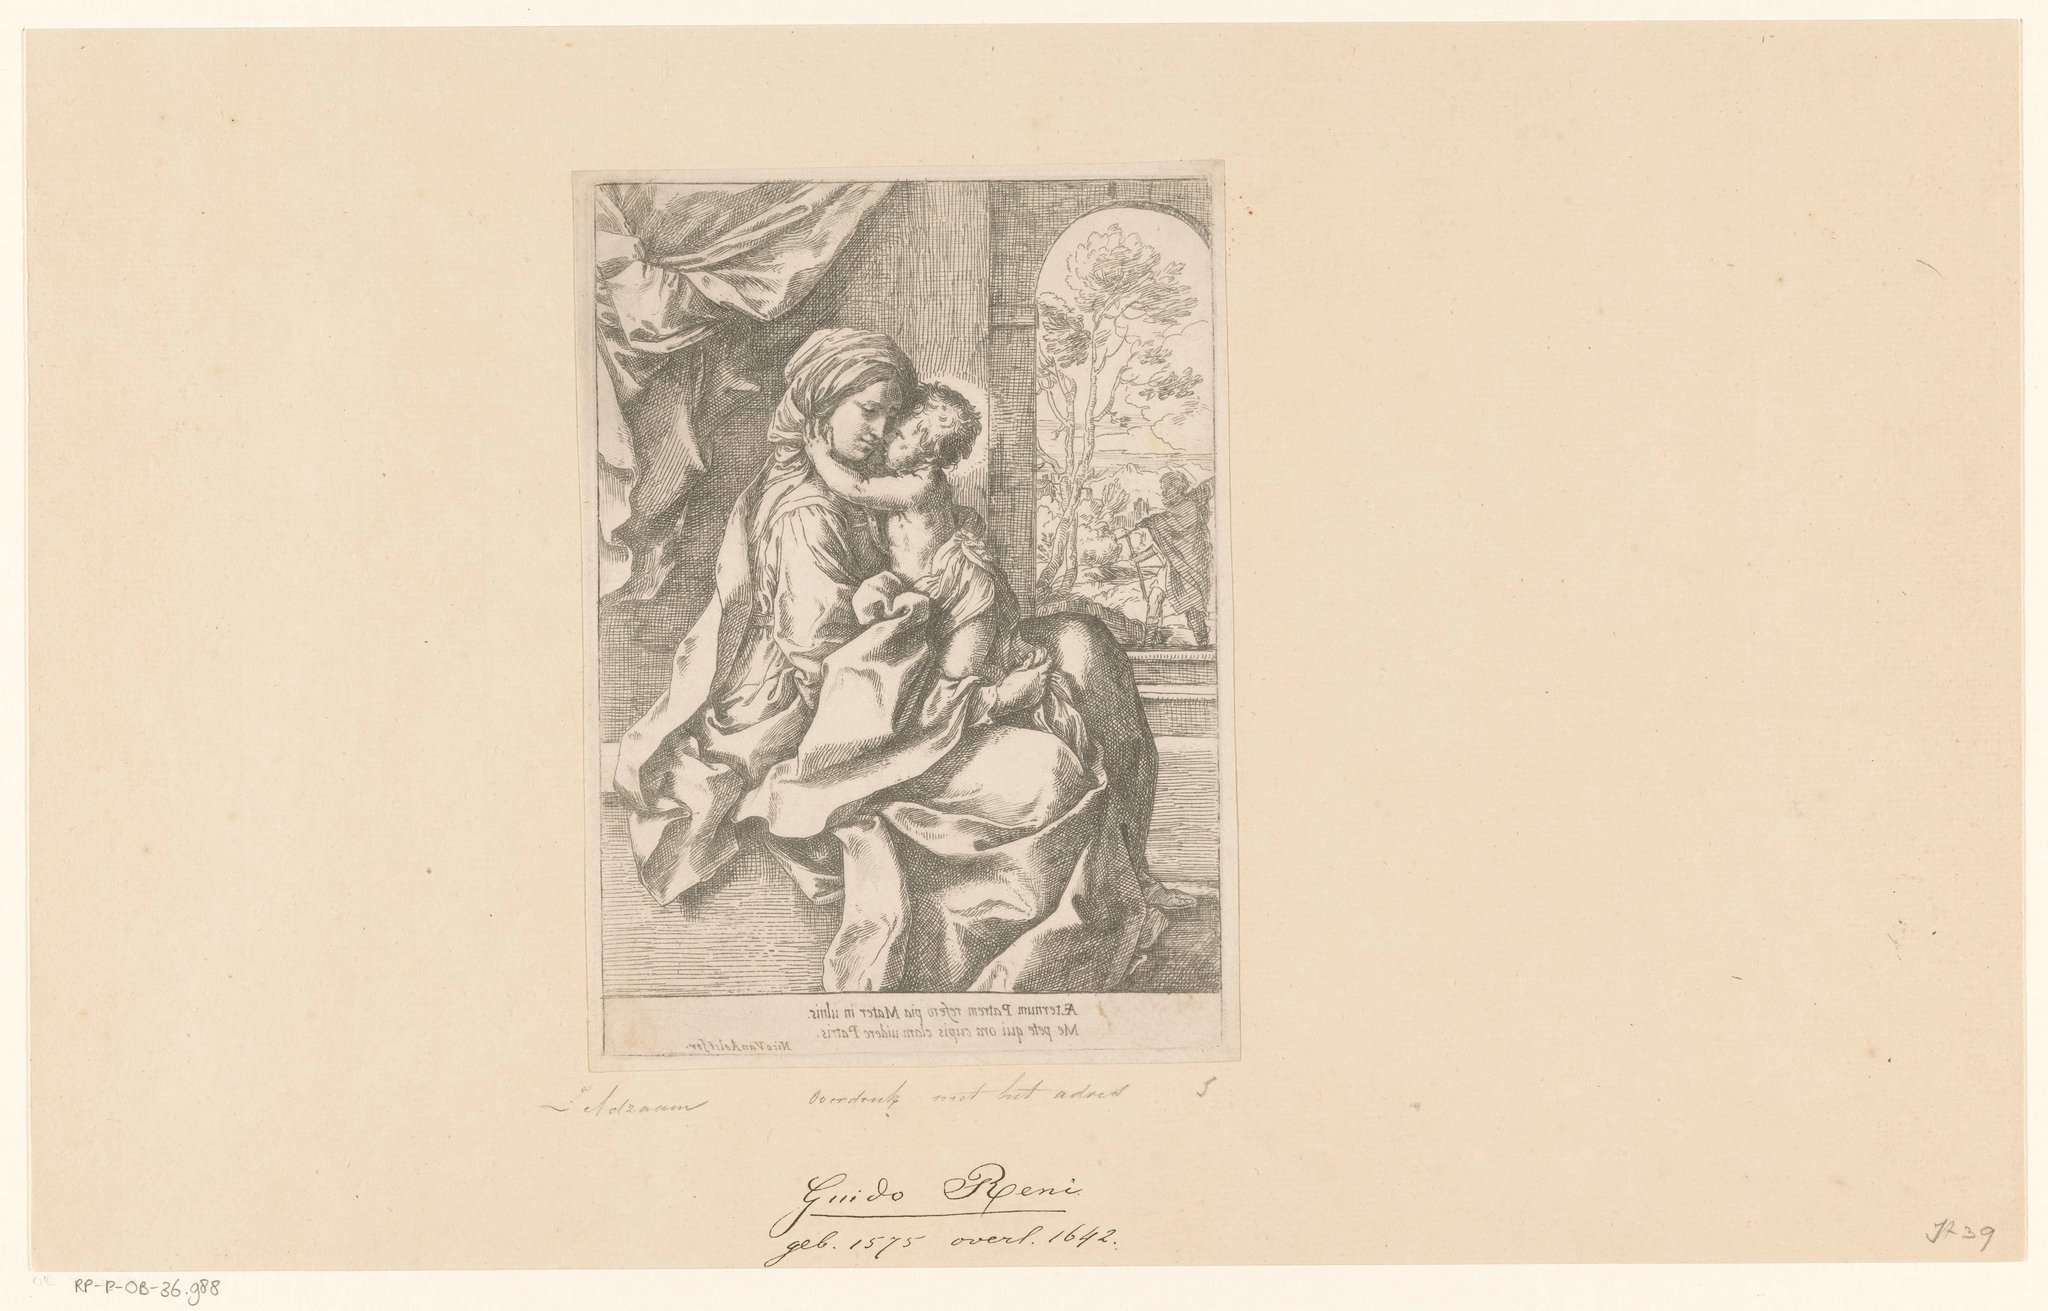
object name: print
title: Maria met Kind en Jozef op de achtergrond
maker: guido reni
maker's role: draughtsman, painter, print maker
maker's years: 1575-1642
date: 1585-1642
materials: paper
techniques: printmaking, etching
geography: italy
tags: madonna: i.e. mary with the christ-child, holy family, and derived representations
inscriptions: collector's mark: Lugt 240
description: Maria zit met het Christuskind op schoot. Op de achtergrond loopt Jozef. Twee regels vers in het Latijn in ondermarge (spiegelbeeldig).